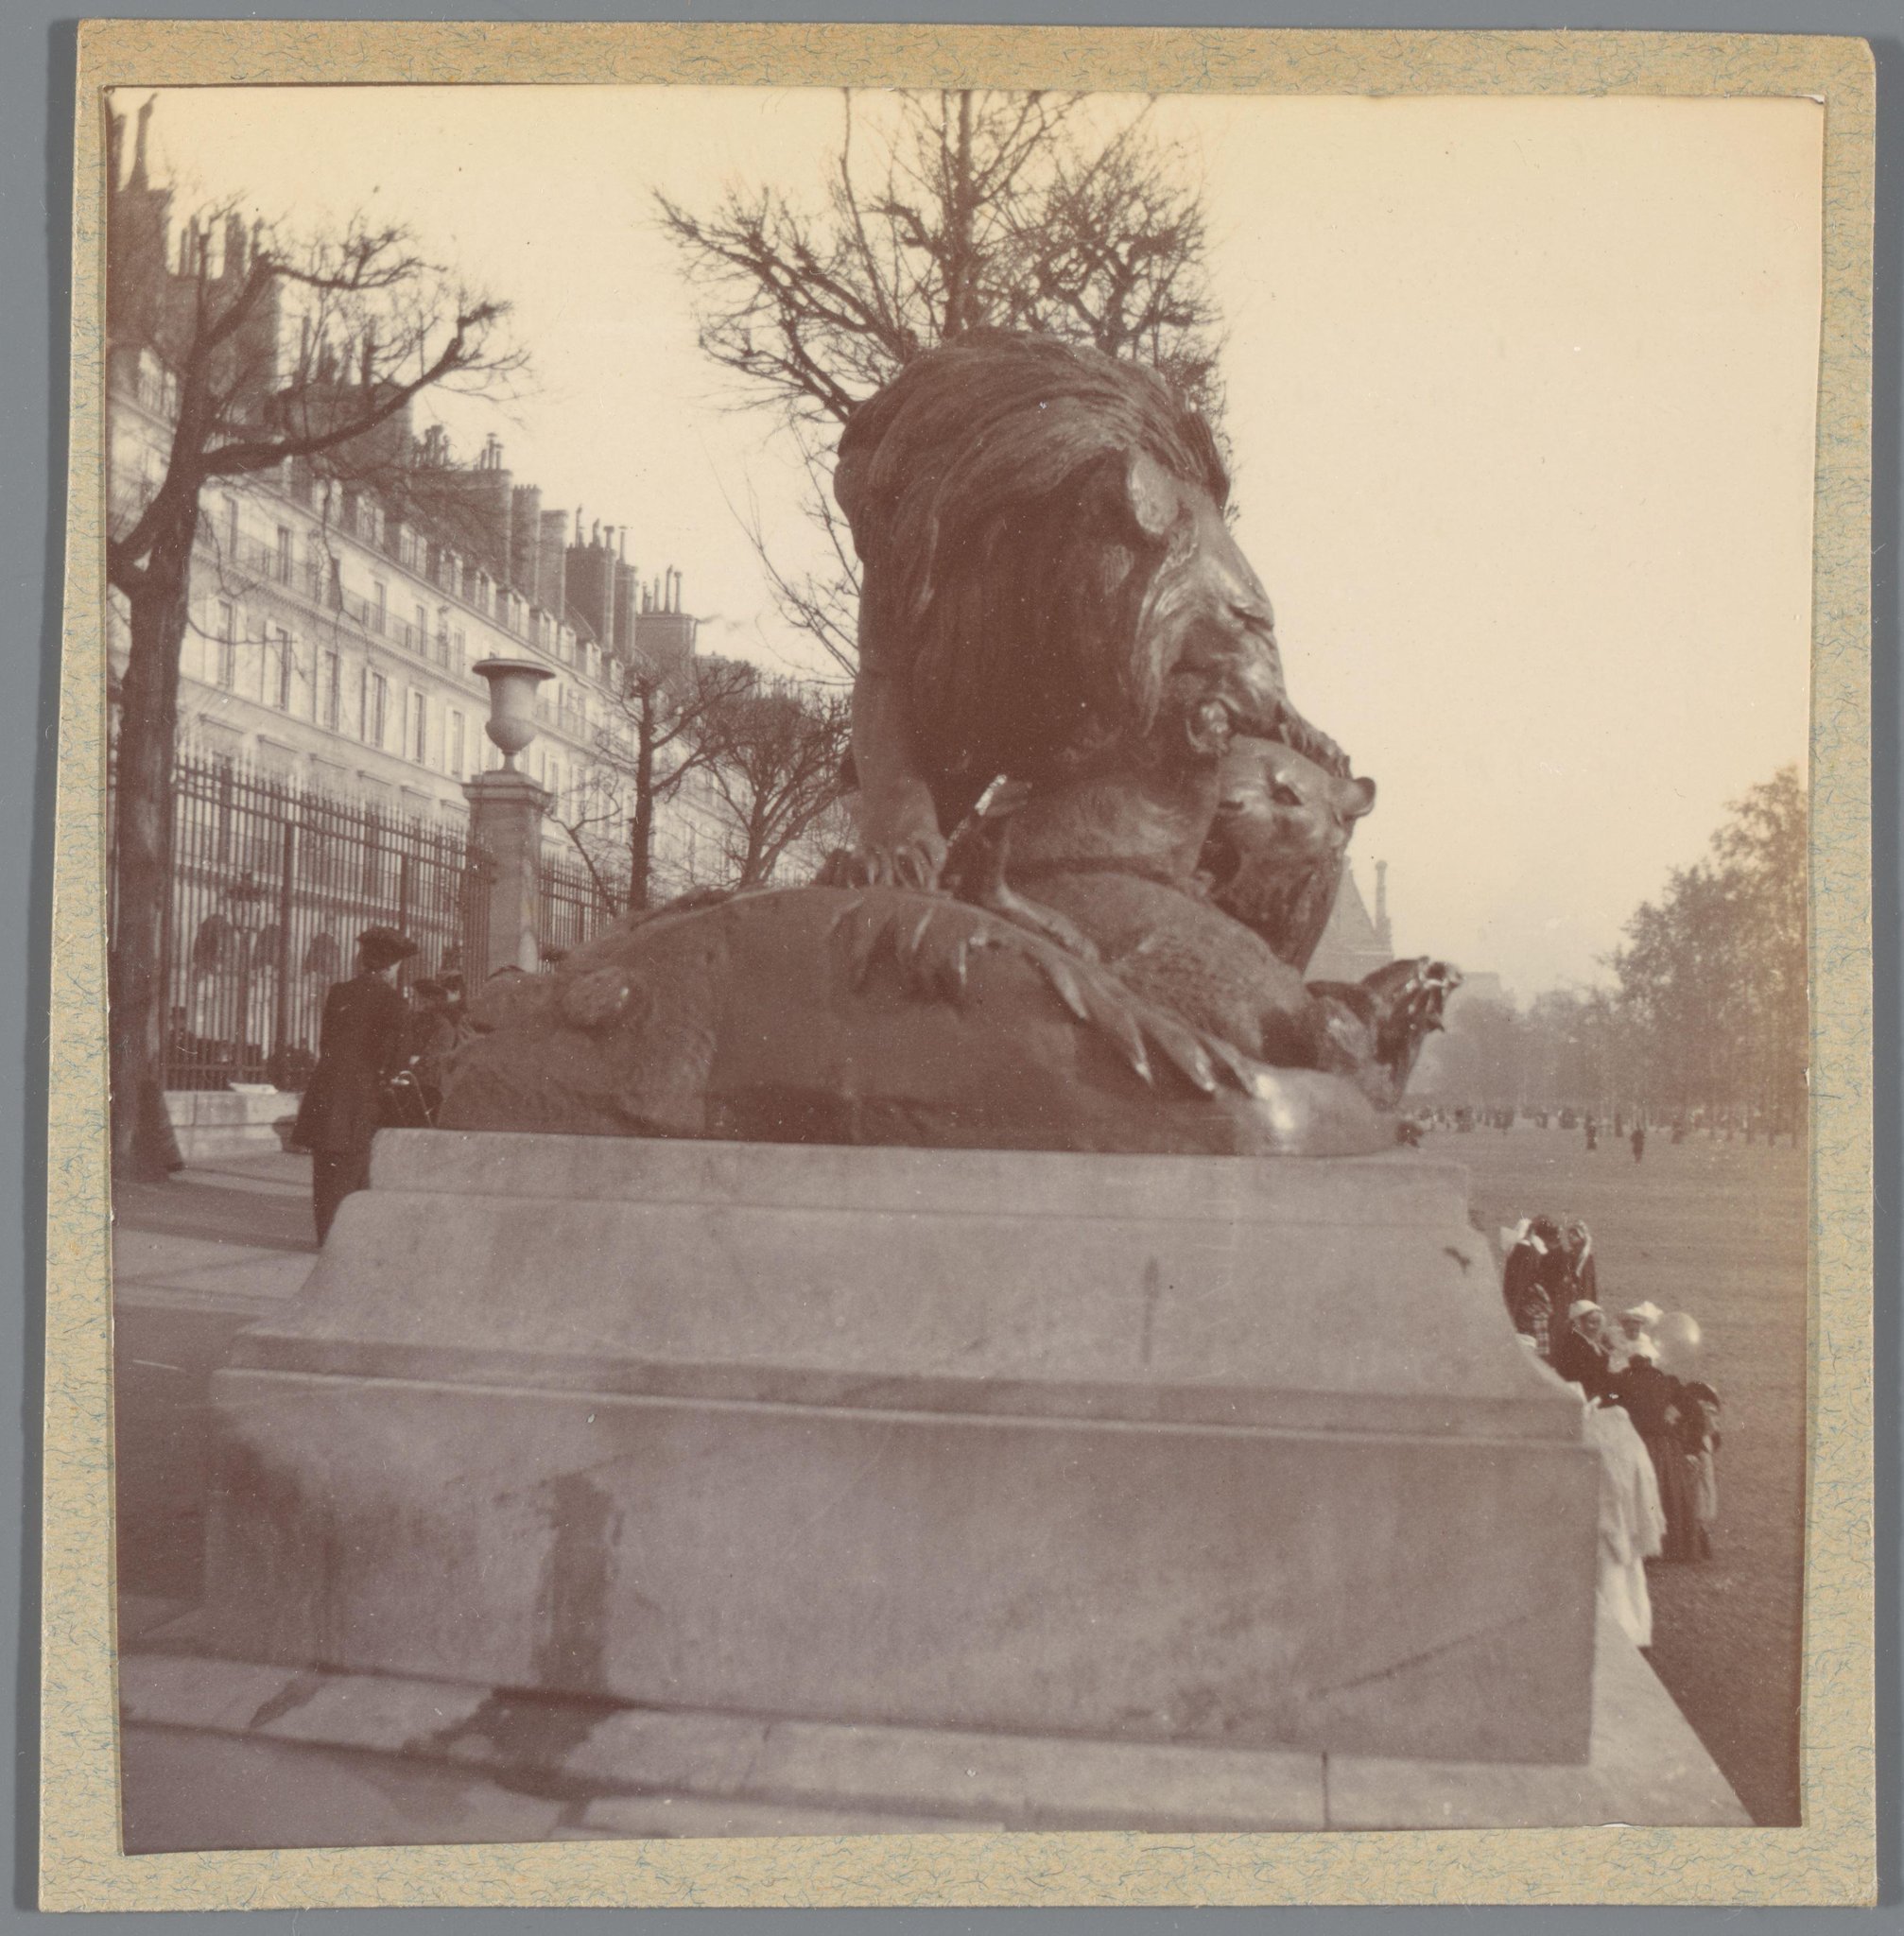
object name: photograph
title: Tuileriën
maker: Anonymous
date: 1900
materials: paper, cardboard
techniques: daylight paper print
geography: paris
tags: piece of sculpture, reproduction of a piece of sculpture, public gardens, park